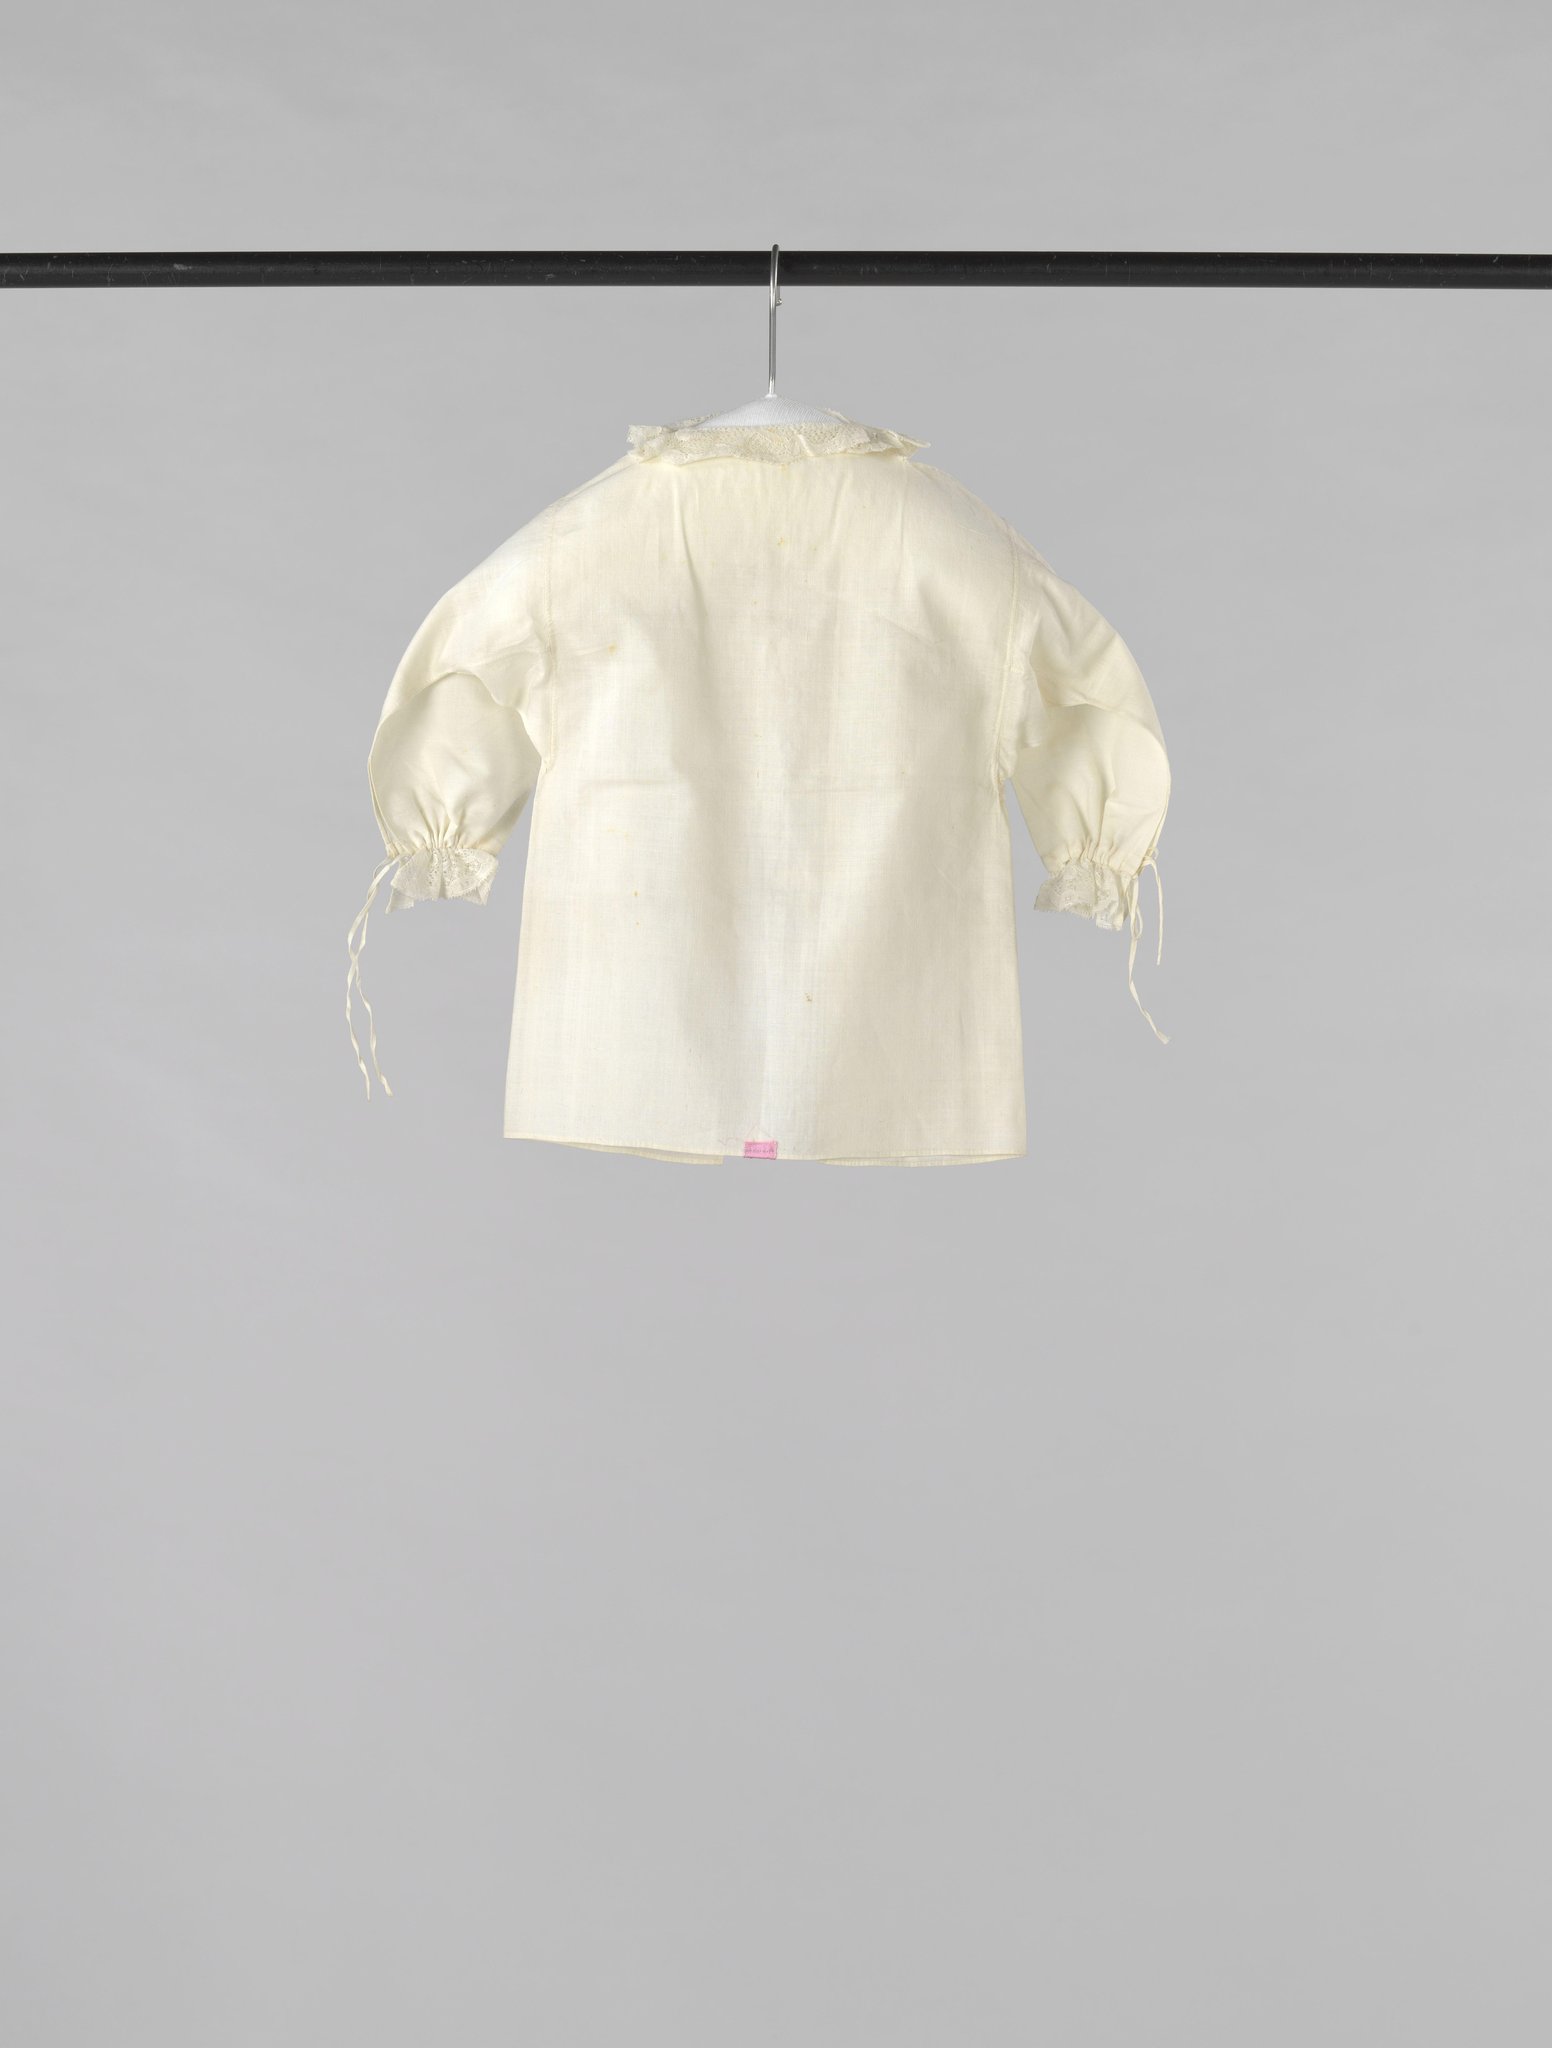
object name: chemise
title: Een kinderhemdje, linnen met Mechelse kloskant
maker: Anonymous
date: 1700-1750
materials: linen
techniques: lace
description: Een kinderhemdje, linnen met Mechelse kloskant.